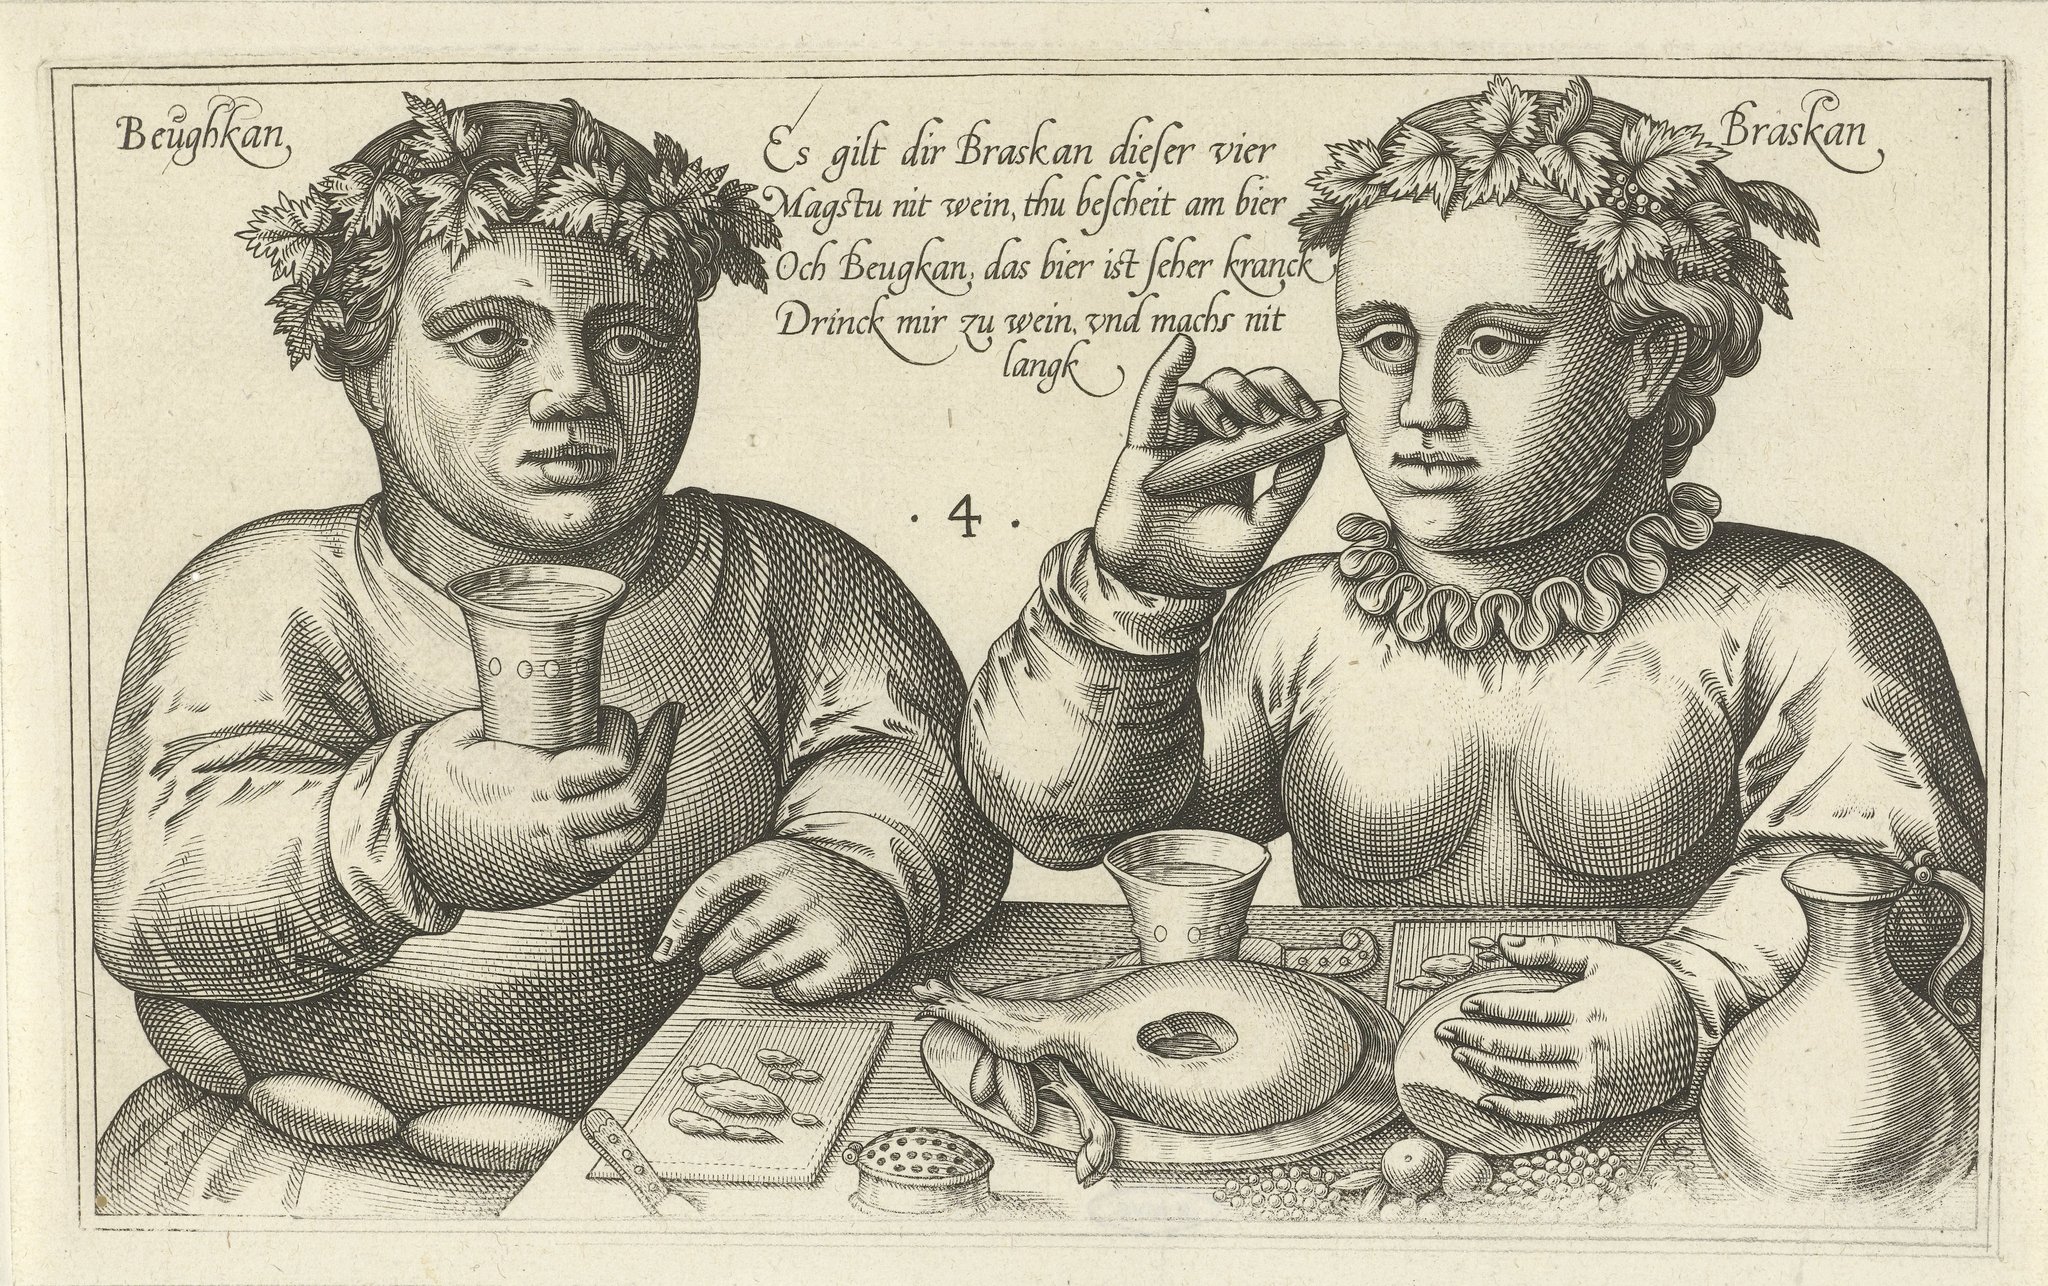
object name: print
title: Woordspelingen over de relatie tussen man en vrouw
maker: julius goltzius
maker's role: draughtsman, print maker, publisher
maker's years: -1595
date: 1560-1595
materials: paper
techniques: engraving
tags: drunkard, satire on marriage, rich kitchen, glutton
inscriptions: collector's mark: Lugt 2228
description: Een rijkgevulde tafel met eten en drinken. Links zit Drinkeboer (Beughkan), een dikke man met een beker in de handen. Rechts zit Veelvraat (Braskan), een dikke vrouw met een worst in de hand. De prent heeft een Duits opschrift op vers. De prent is deel van een serie met woordspelingen over de relatie tussen man en vrouw als onderwerp.